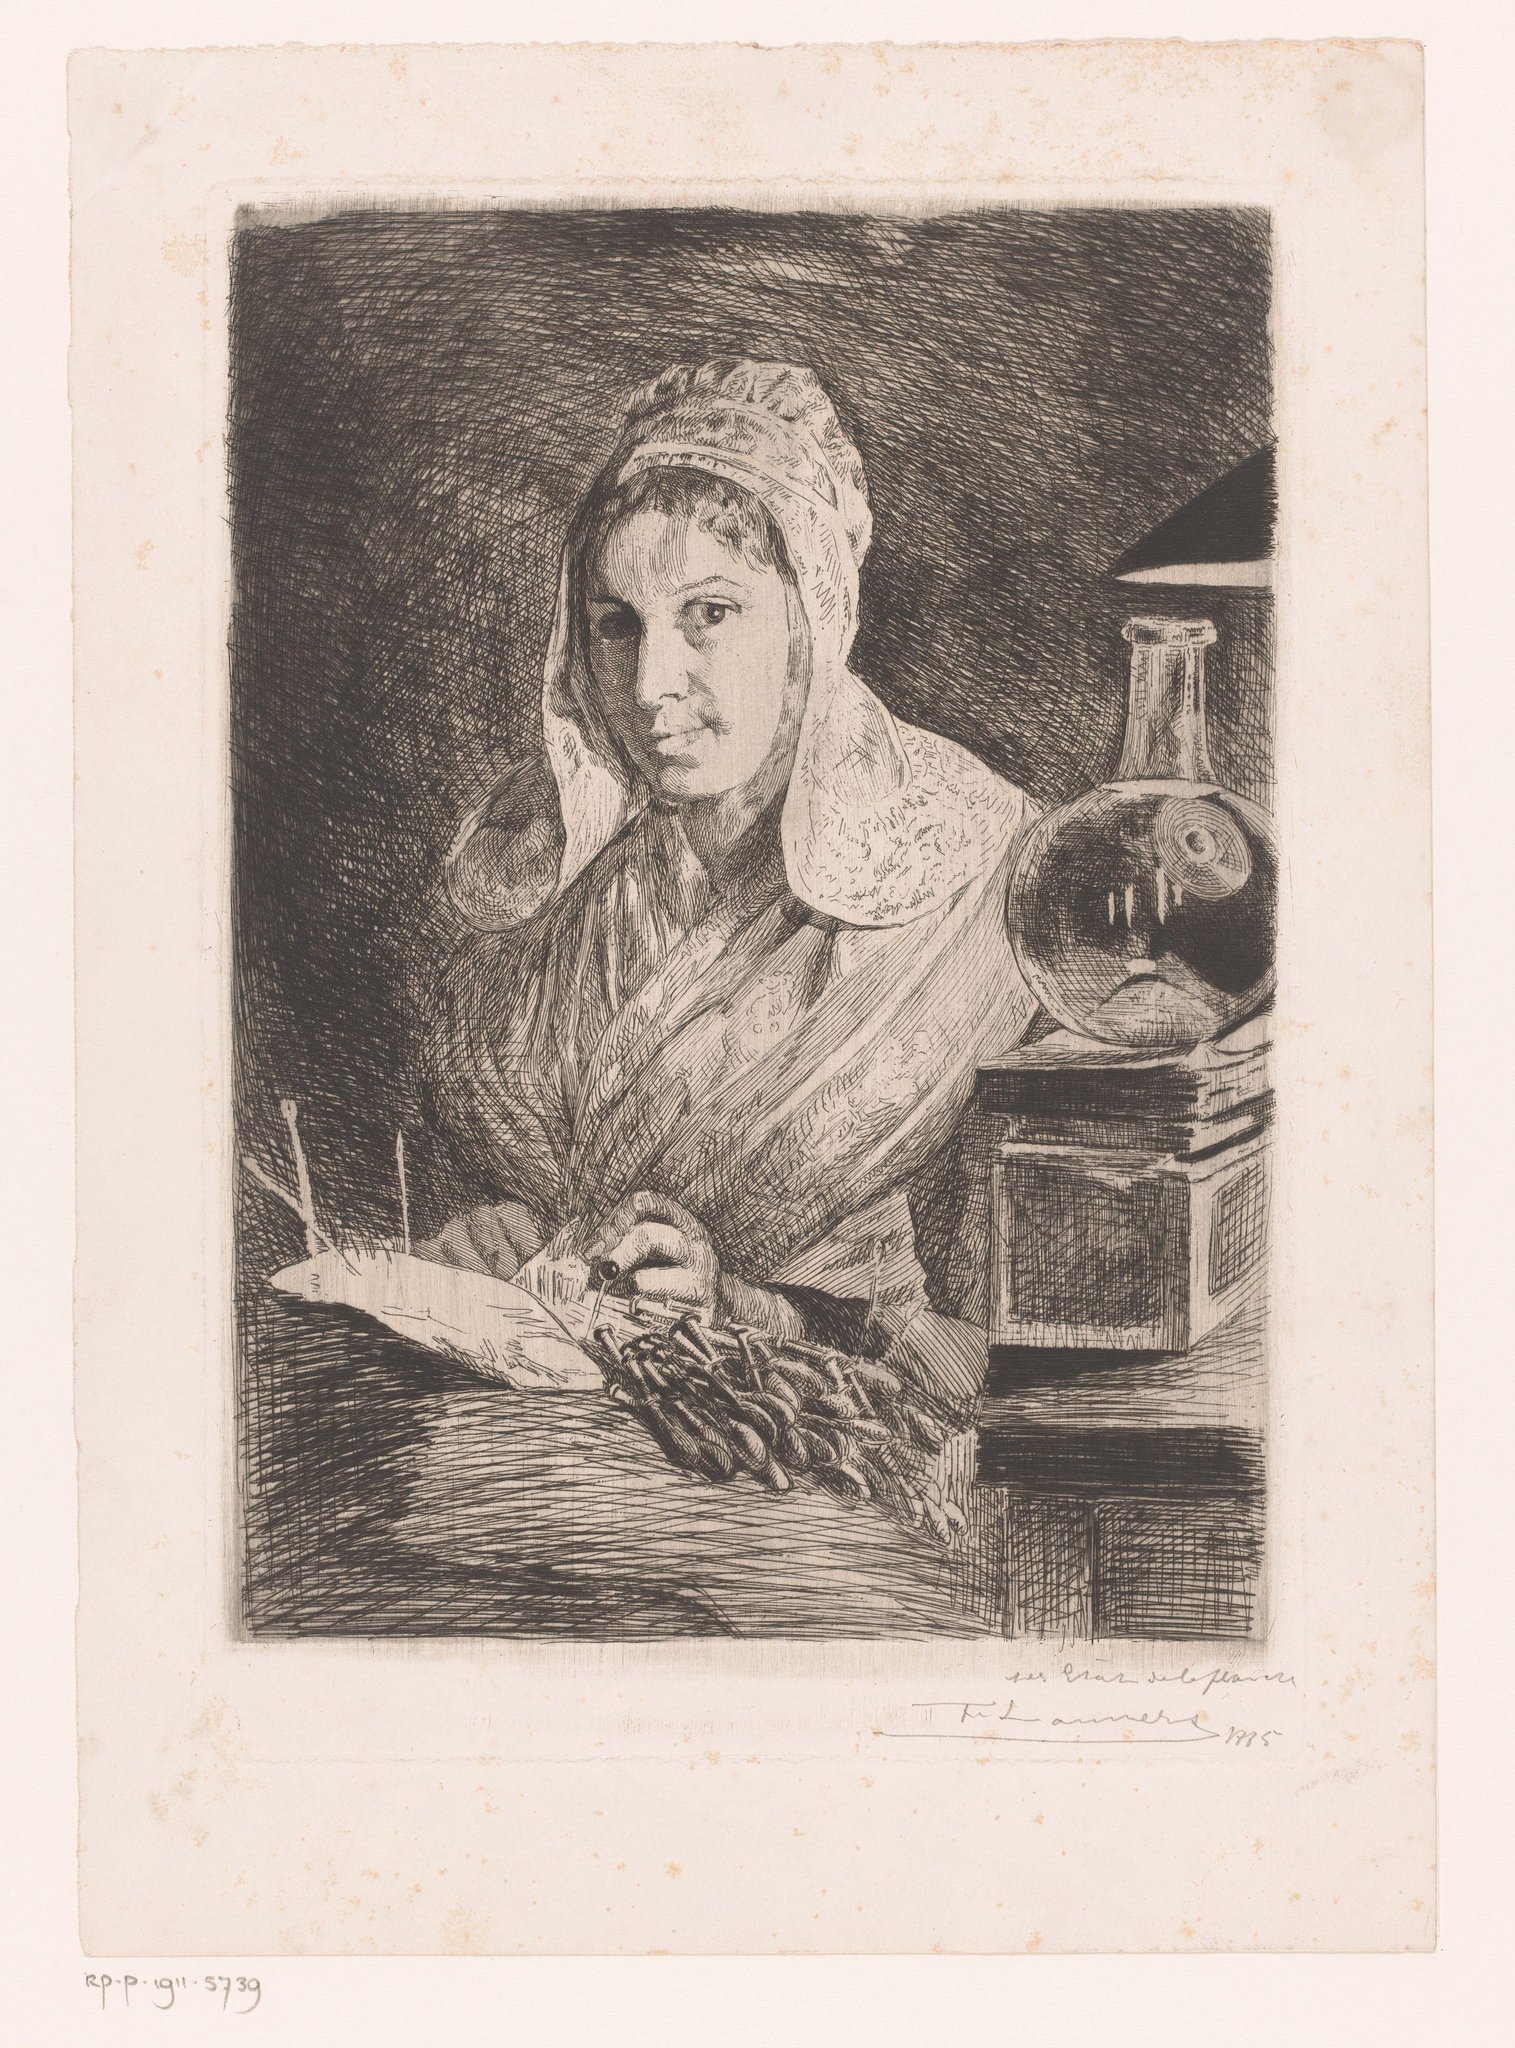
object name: print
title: Kantklossende vrouw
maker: frans lauwers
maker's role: print maker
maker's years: 1854-1931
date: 1885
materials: paper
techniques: drypoint, etching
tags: lace-making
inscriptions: collector's mark: Lugt 2228, annotation: ‘1er Etat de la planche’